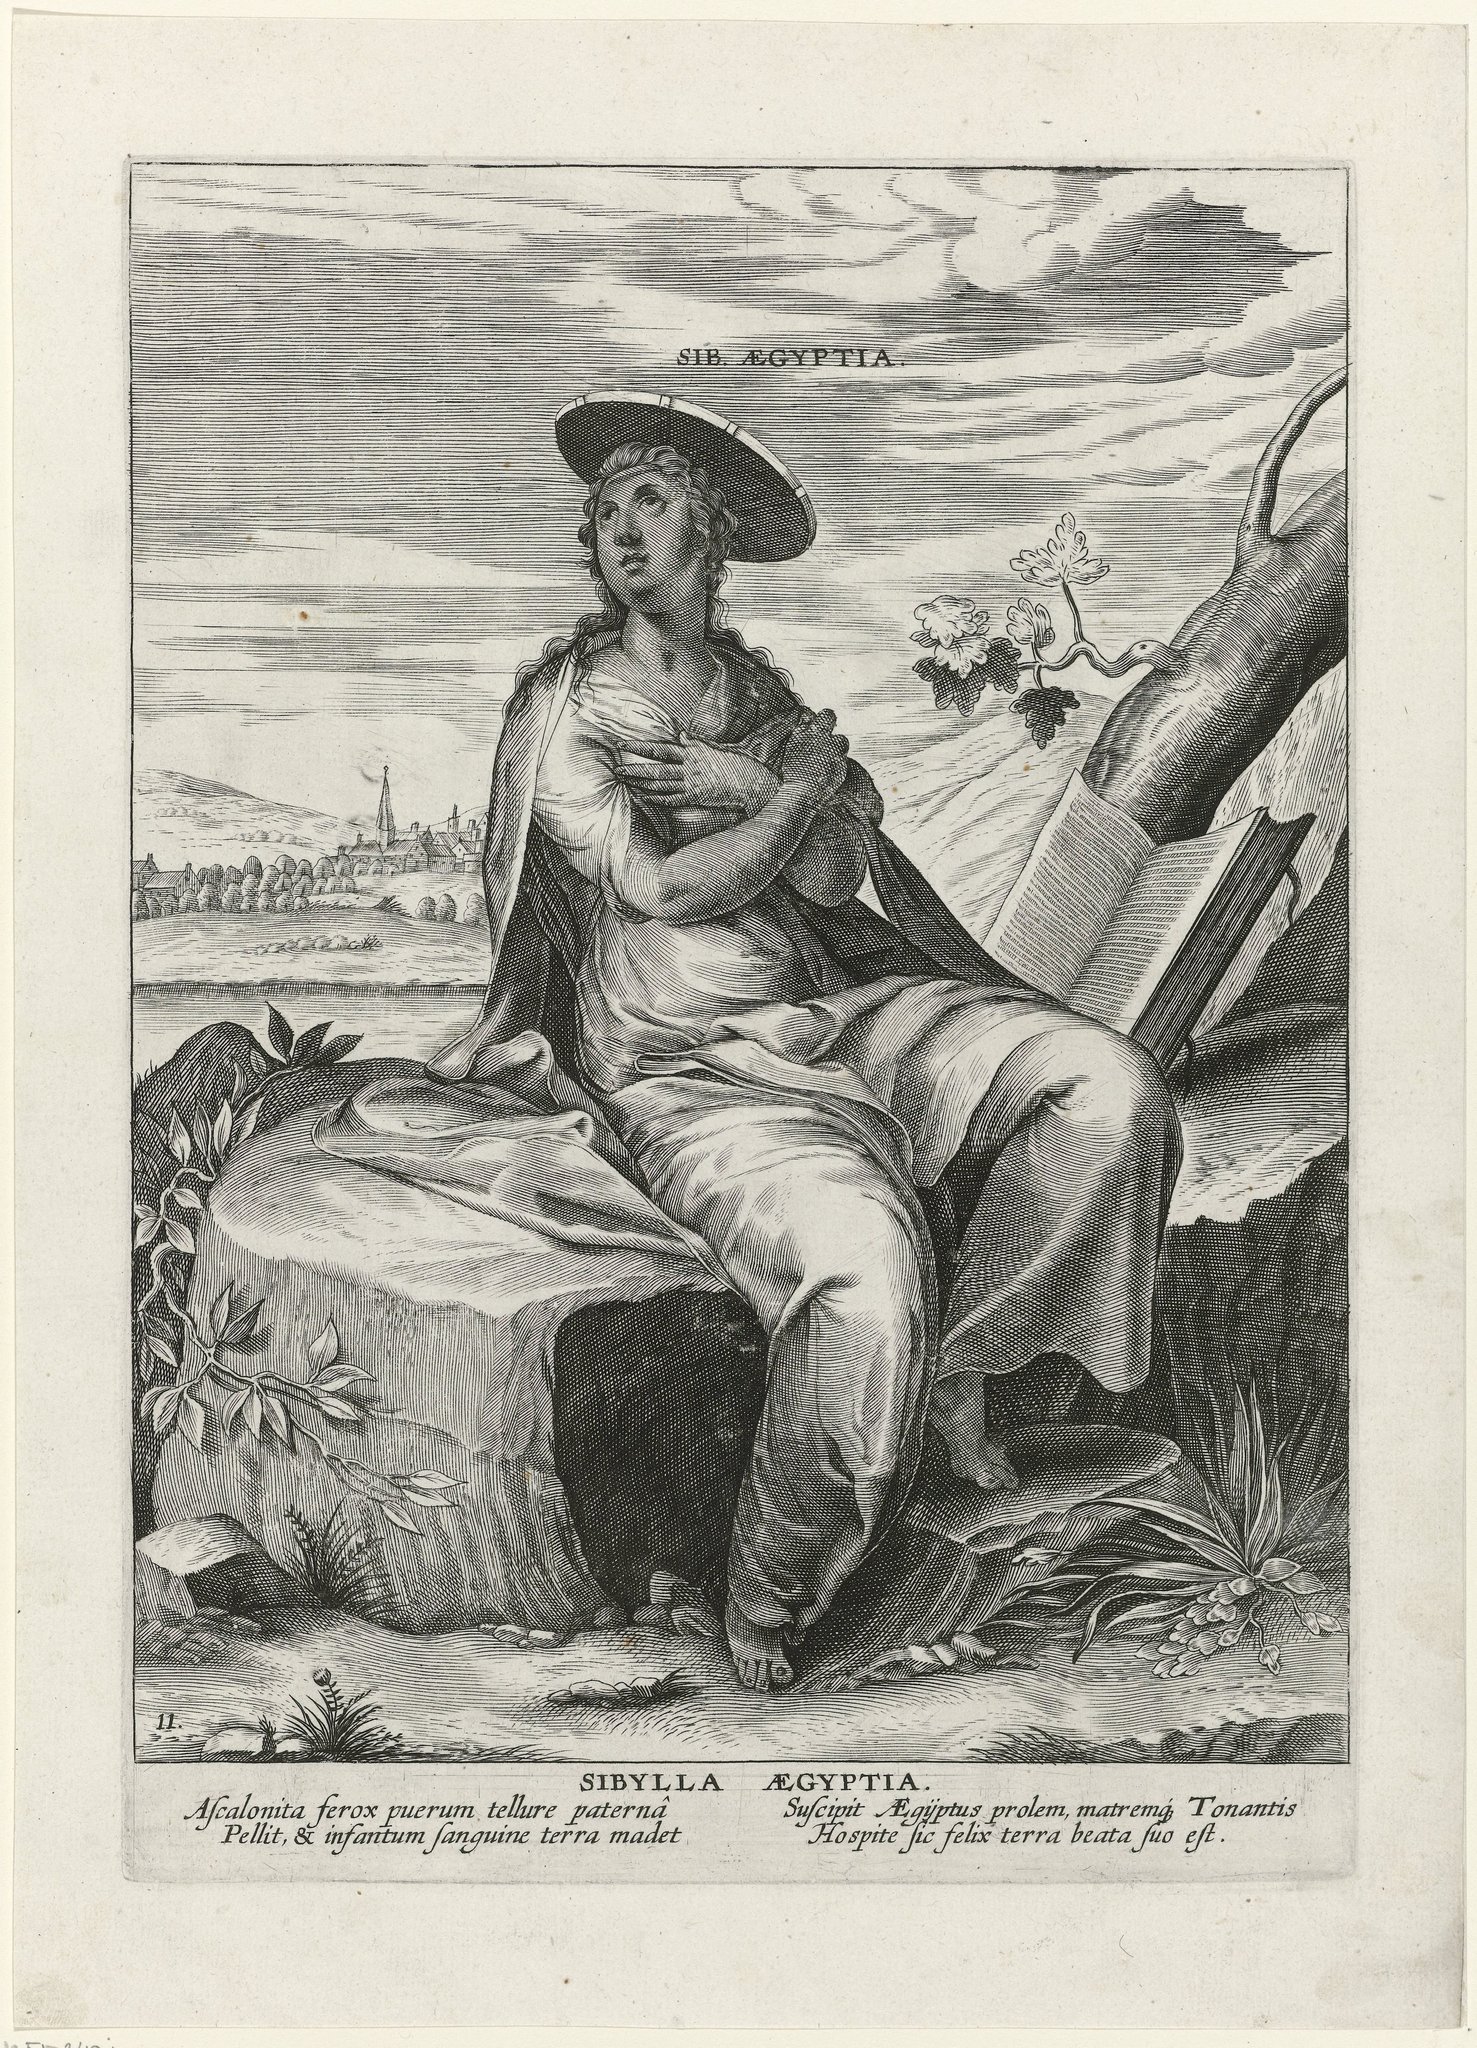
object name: print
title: Sibylla Aegyptia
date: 1610-1676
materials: paper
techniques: engraving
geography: antwerp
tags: sibyls (with name)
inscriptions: collector's mark: Lugt 2228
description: De Sibille van Egypte zit op een rotsblok. Naast haar ligt een open boek. De prent heeft een Latijns onderschrift en is een van twee anonieme prenten in de 17de eeuw toegevoegd aan de serie van Sibillen gemaakt door Philips Galle in 1575.